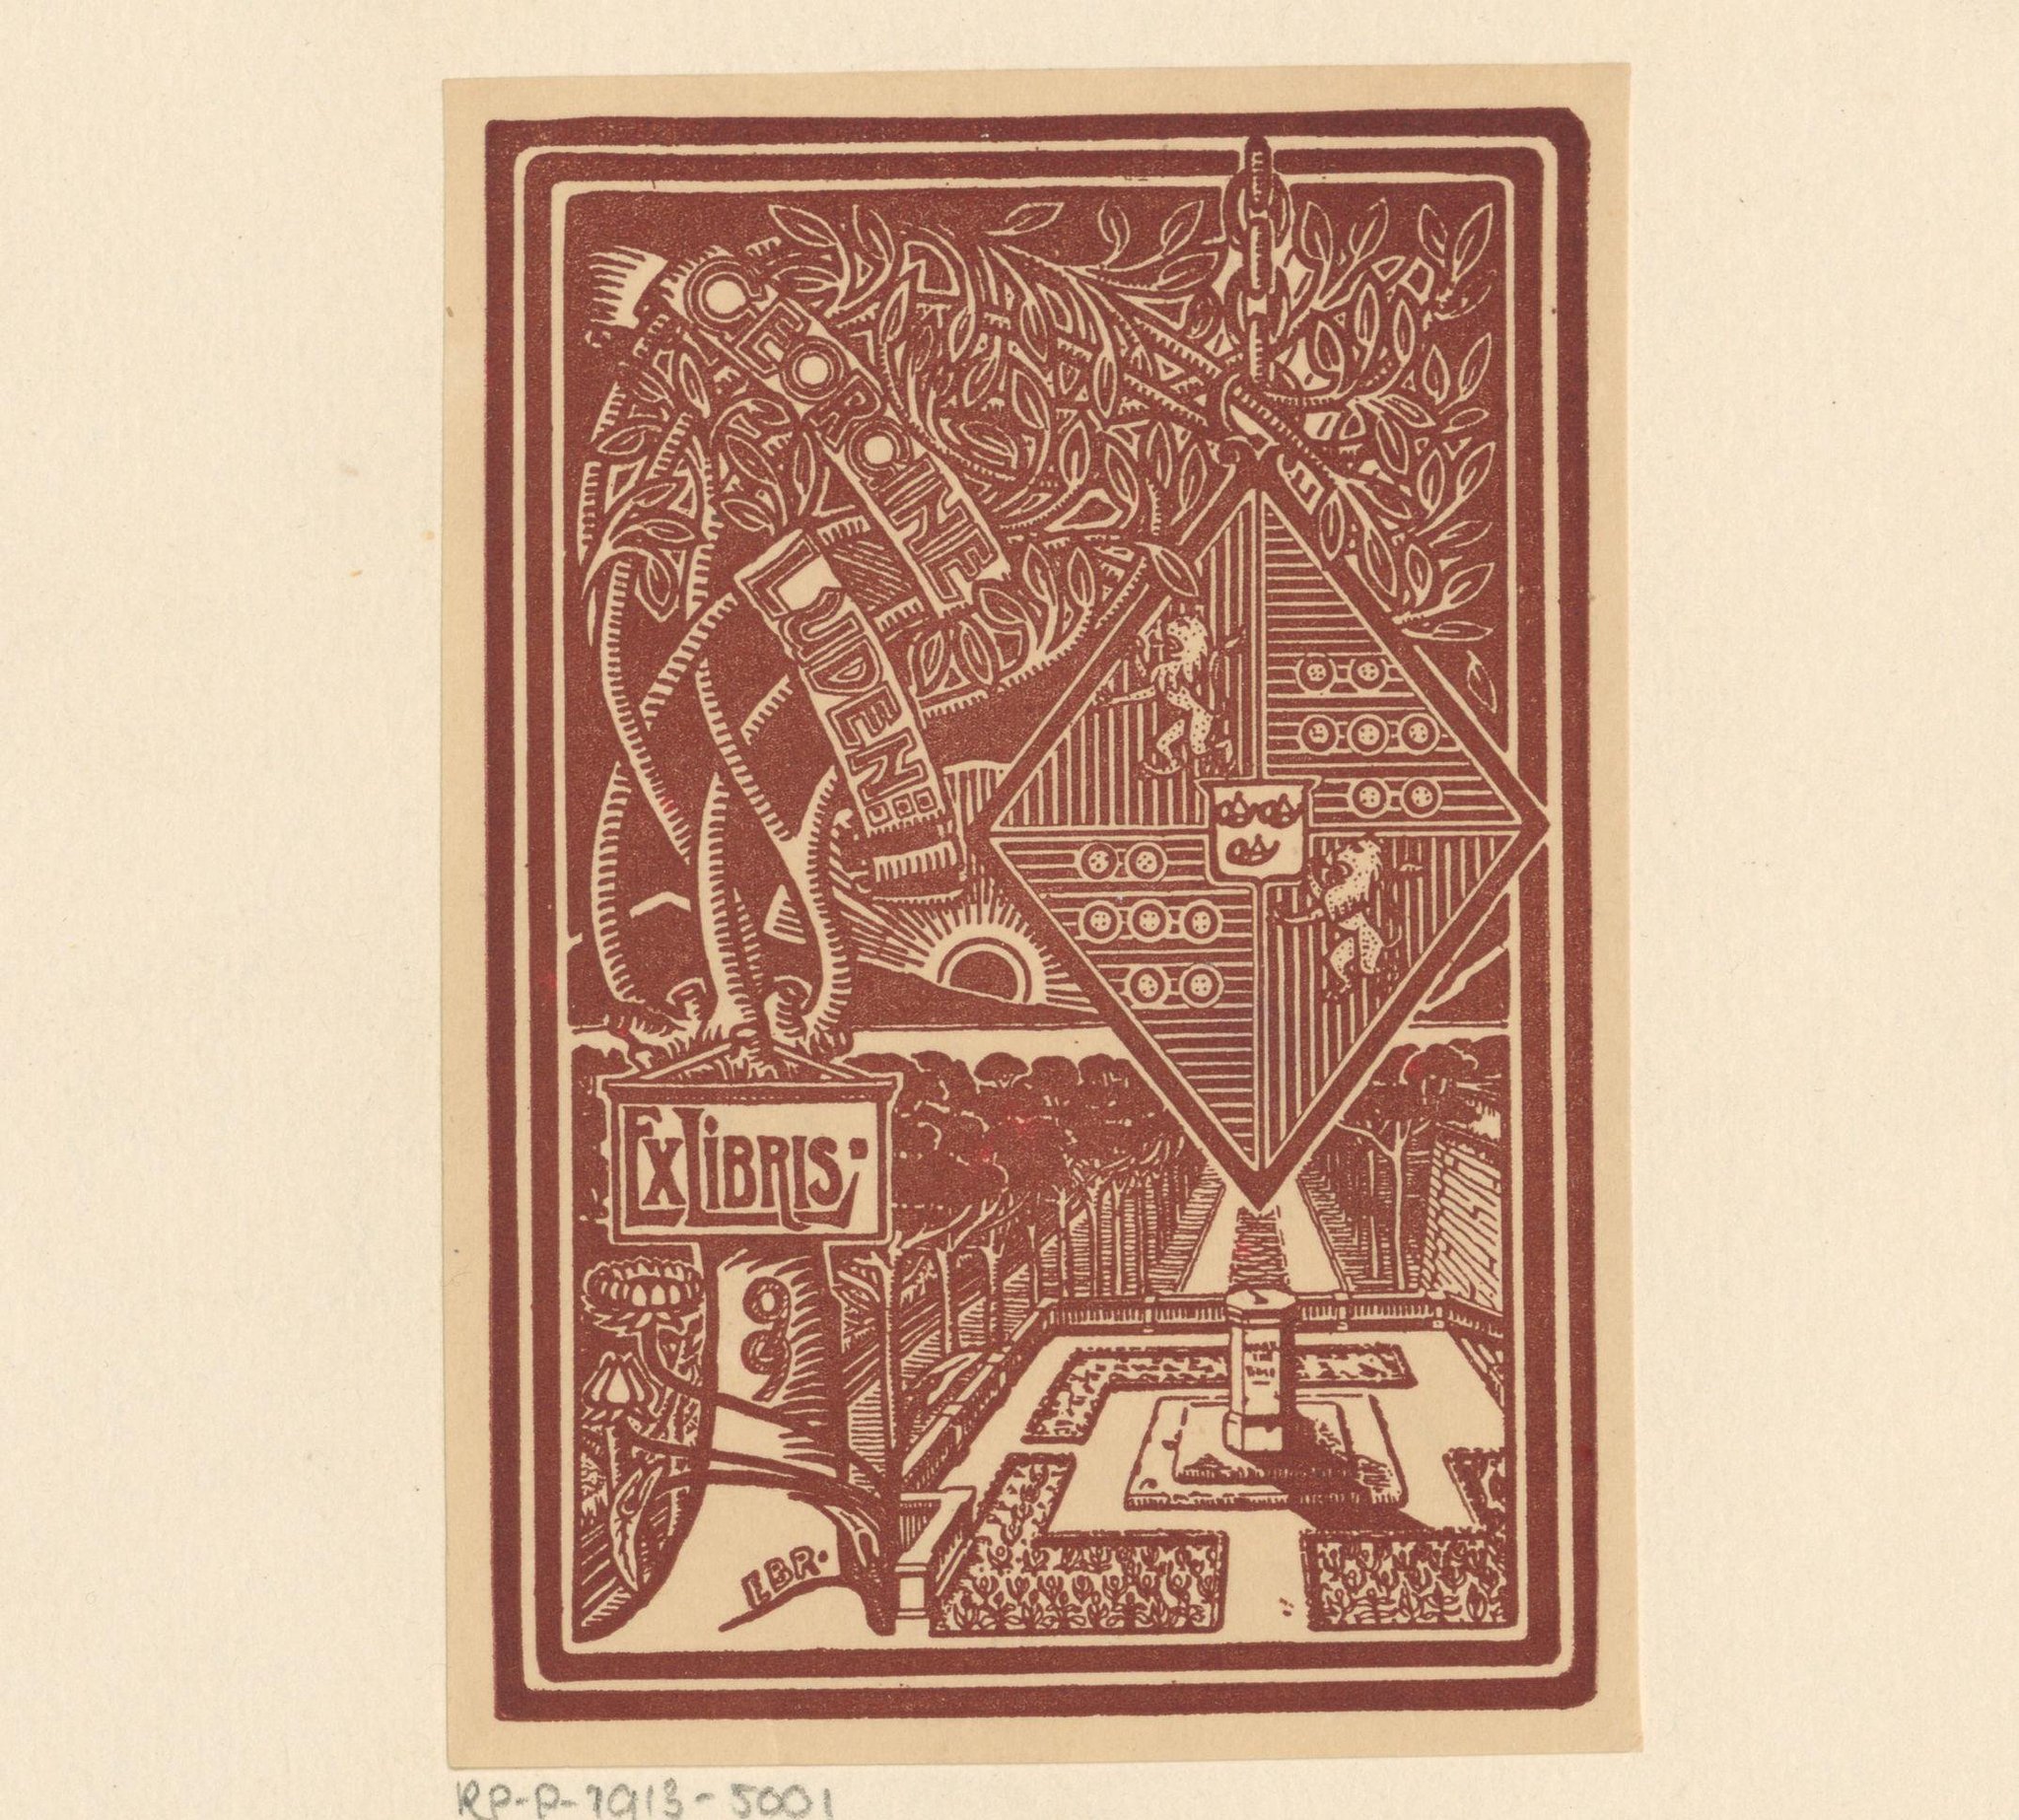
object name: bookplate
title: Ex libris van Georgine Luden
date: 1899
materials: paper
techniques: printing block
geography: england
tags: calendar, almanac, garden, armorial bearing, heraldry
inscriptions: collector's mark: Lugt 2233, collector's mark: Lugt 2760